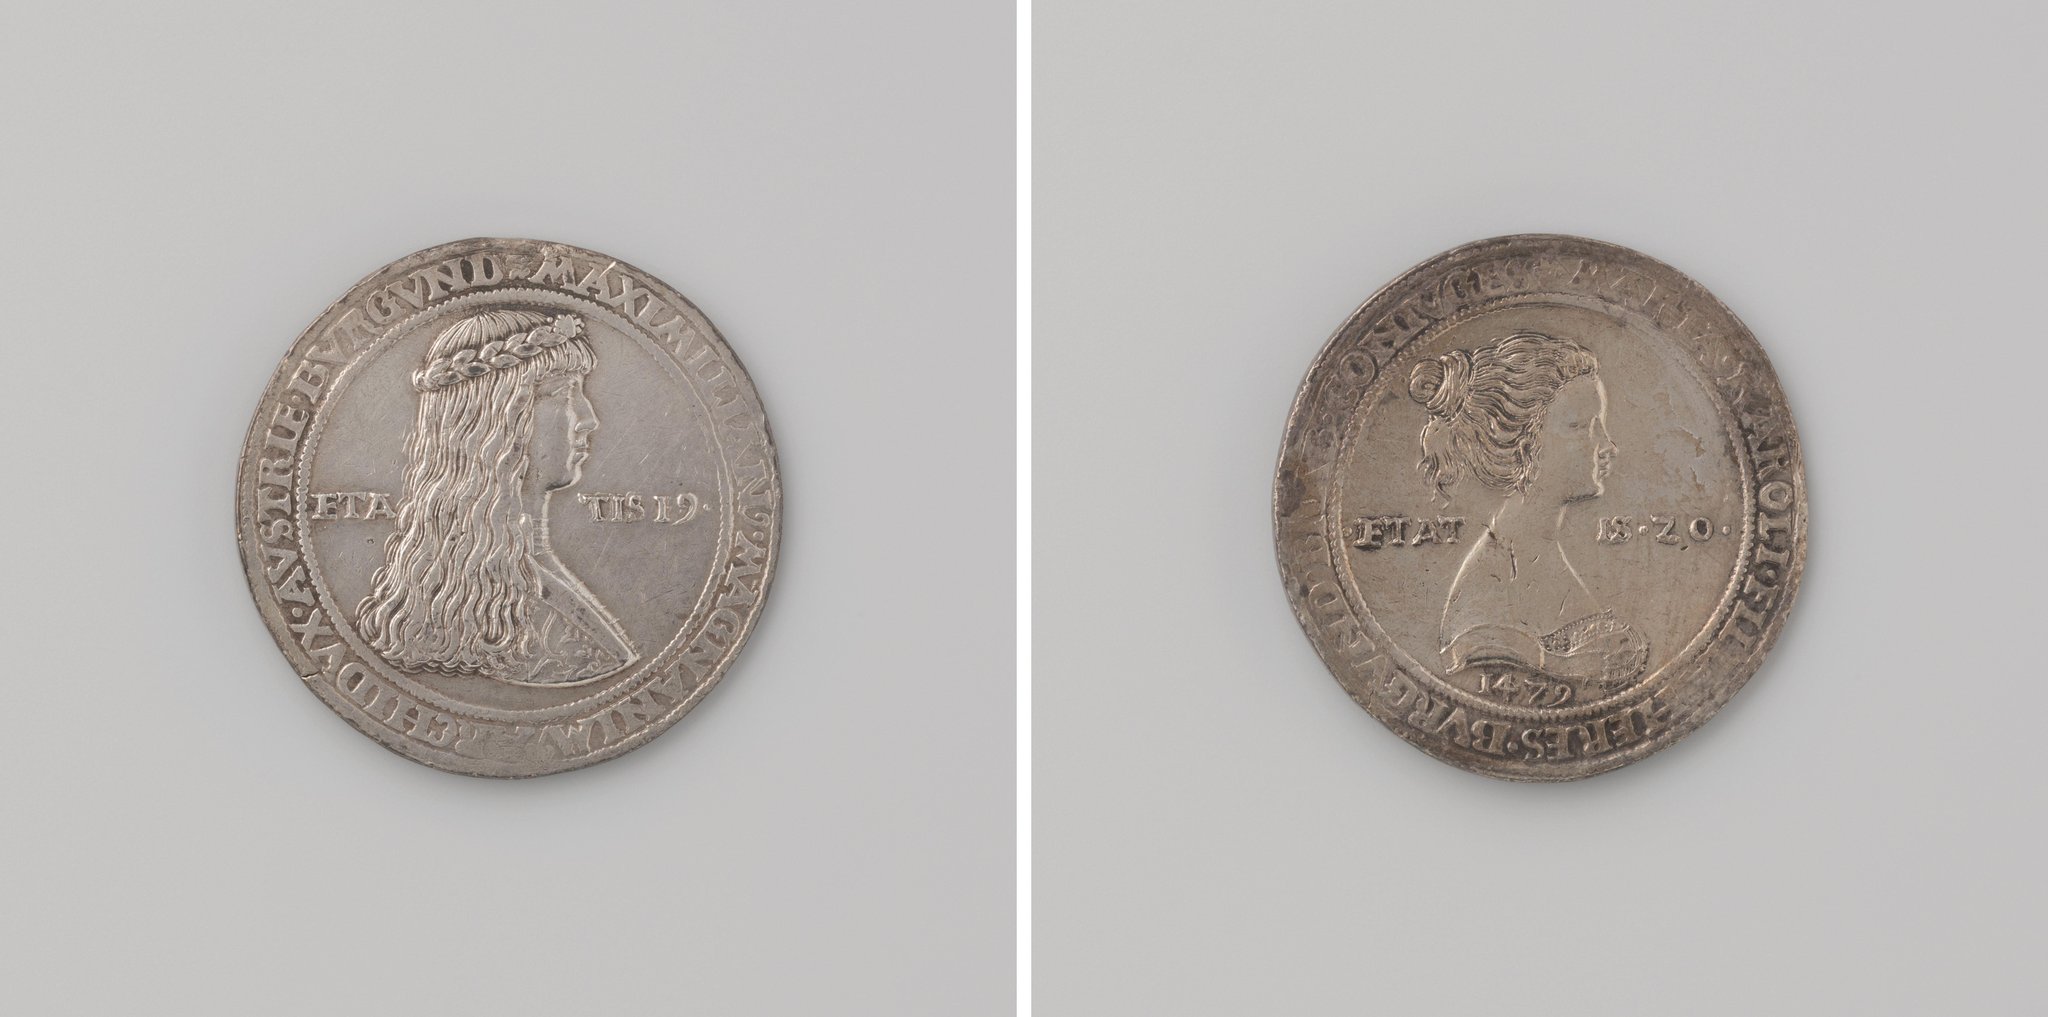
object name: history medal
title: Maximiliaan, aartshertog van Oostenrijk en Maria, hertogin van Bourgondie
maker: gian marco cavalli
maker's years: 1454-1508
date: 1506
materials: silver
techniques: striking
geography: hall am inn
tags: brussels, maria (hertogin van bourgondië), maximilian i (holy roman emperor)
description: Zilveren penning. Voorzijde: borststuk man met lauwerkrans tussen opschrift, binnen omschrift. Keerzijde: borststuk vrouw tussen opschrift, binnen omschrift